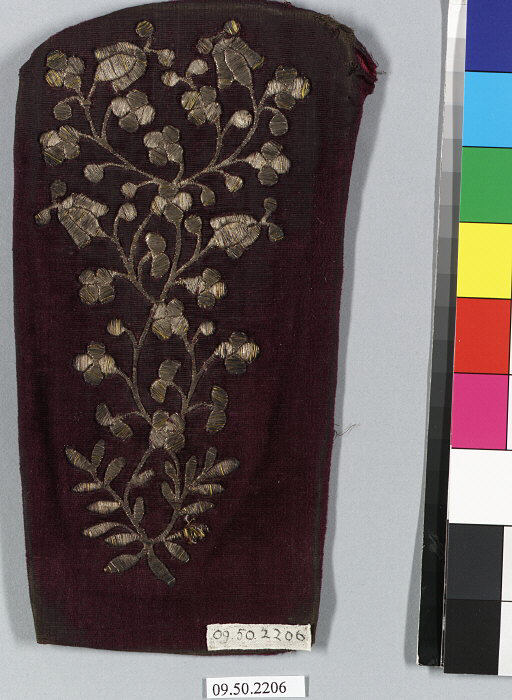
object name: plastron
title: Plastron (?)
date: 1801-1900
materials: metal thread, velvet